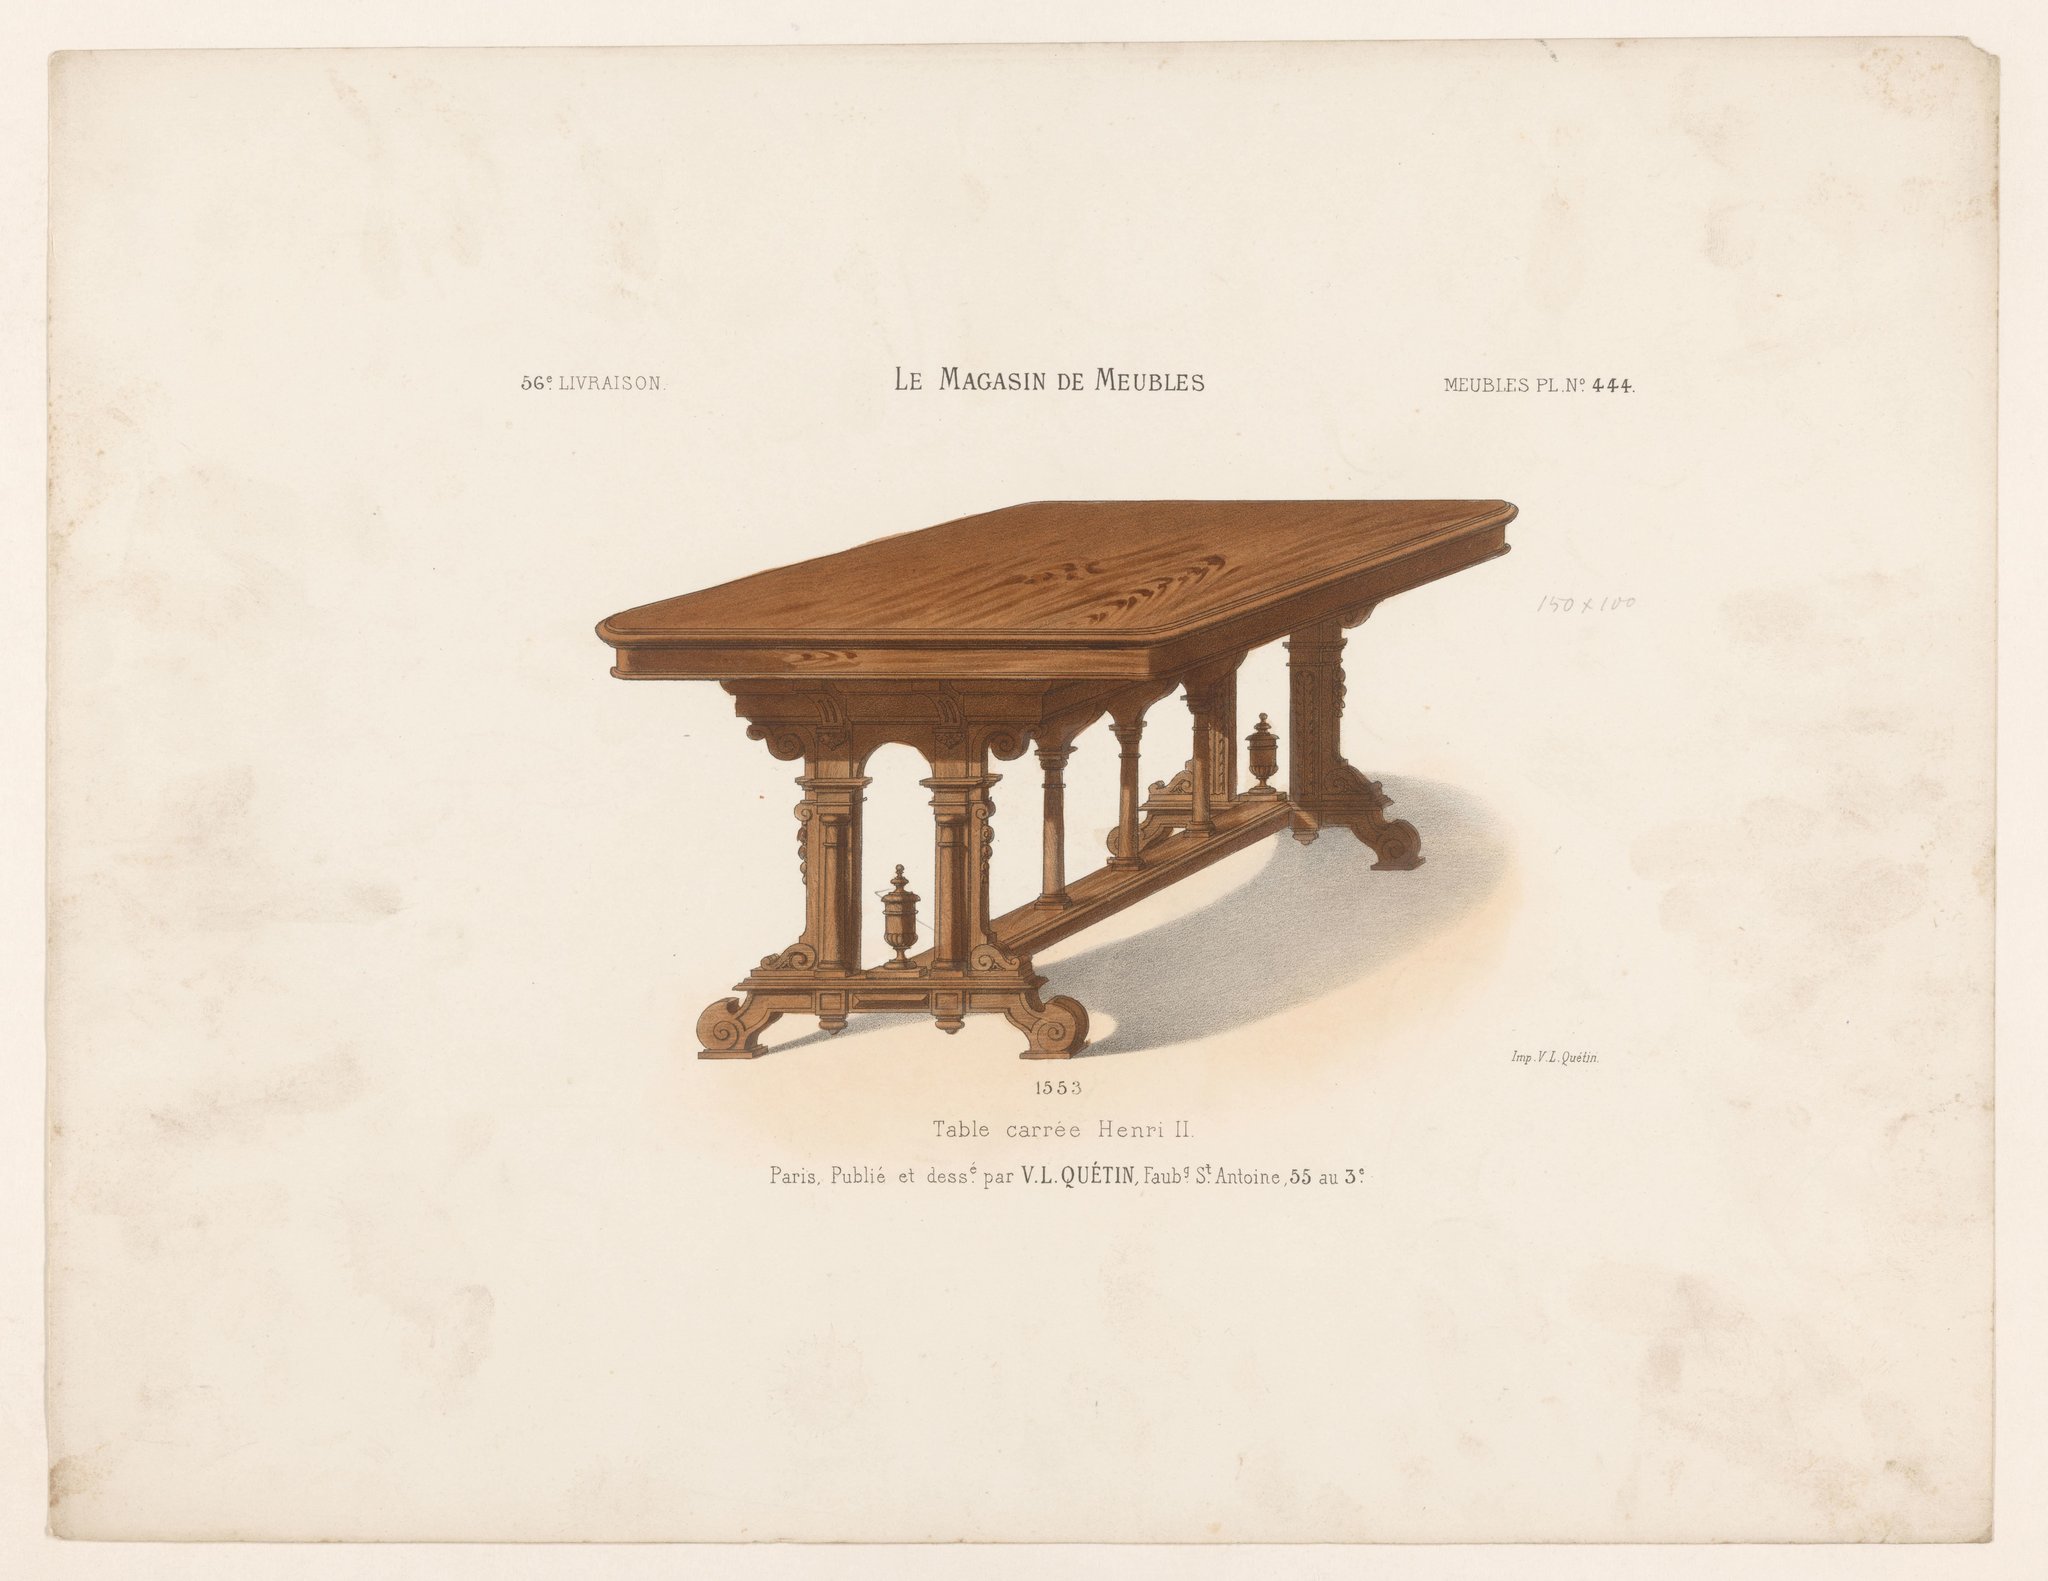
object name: print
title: Le Magasin de Meubles / Meubles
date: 1878-1904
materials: paper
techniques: hand coloring, lithograph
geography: paris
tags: table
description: Een rechthoekige tafel in de Henrik II-stijl. Prent uit 56e Livraison.